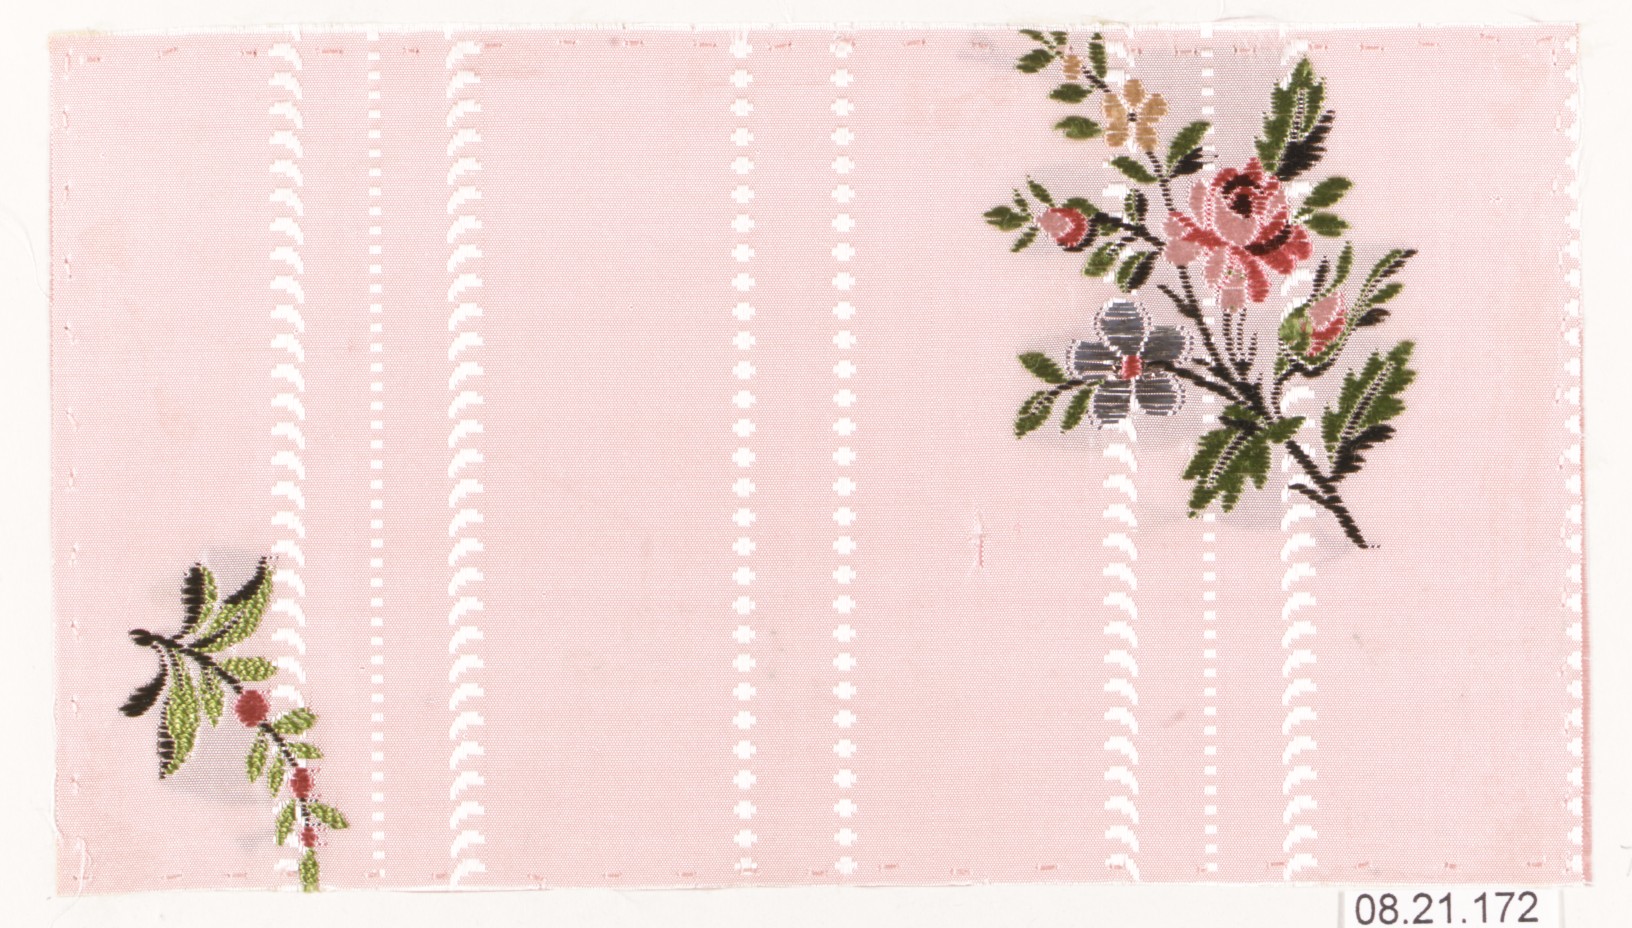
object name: textile sample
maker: Anonymous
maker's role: designer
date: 1900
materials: silk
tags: flowers